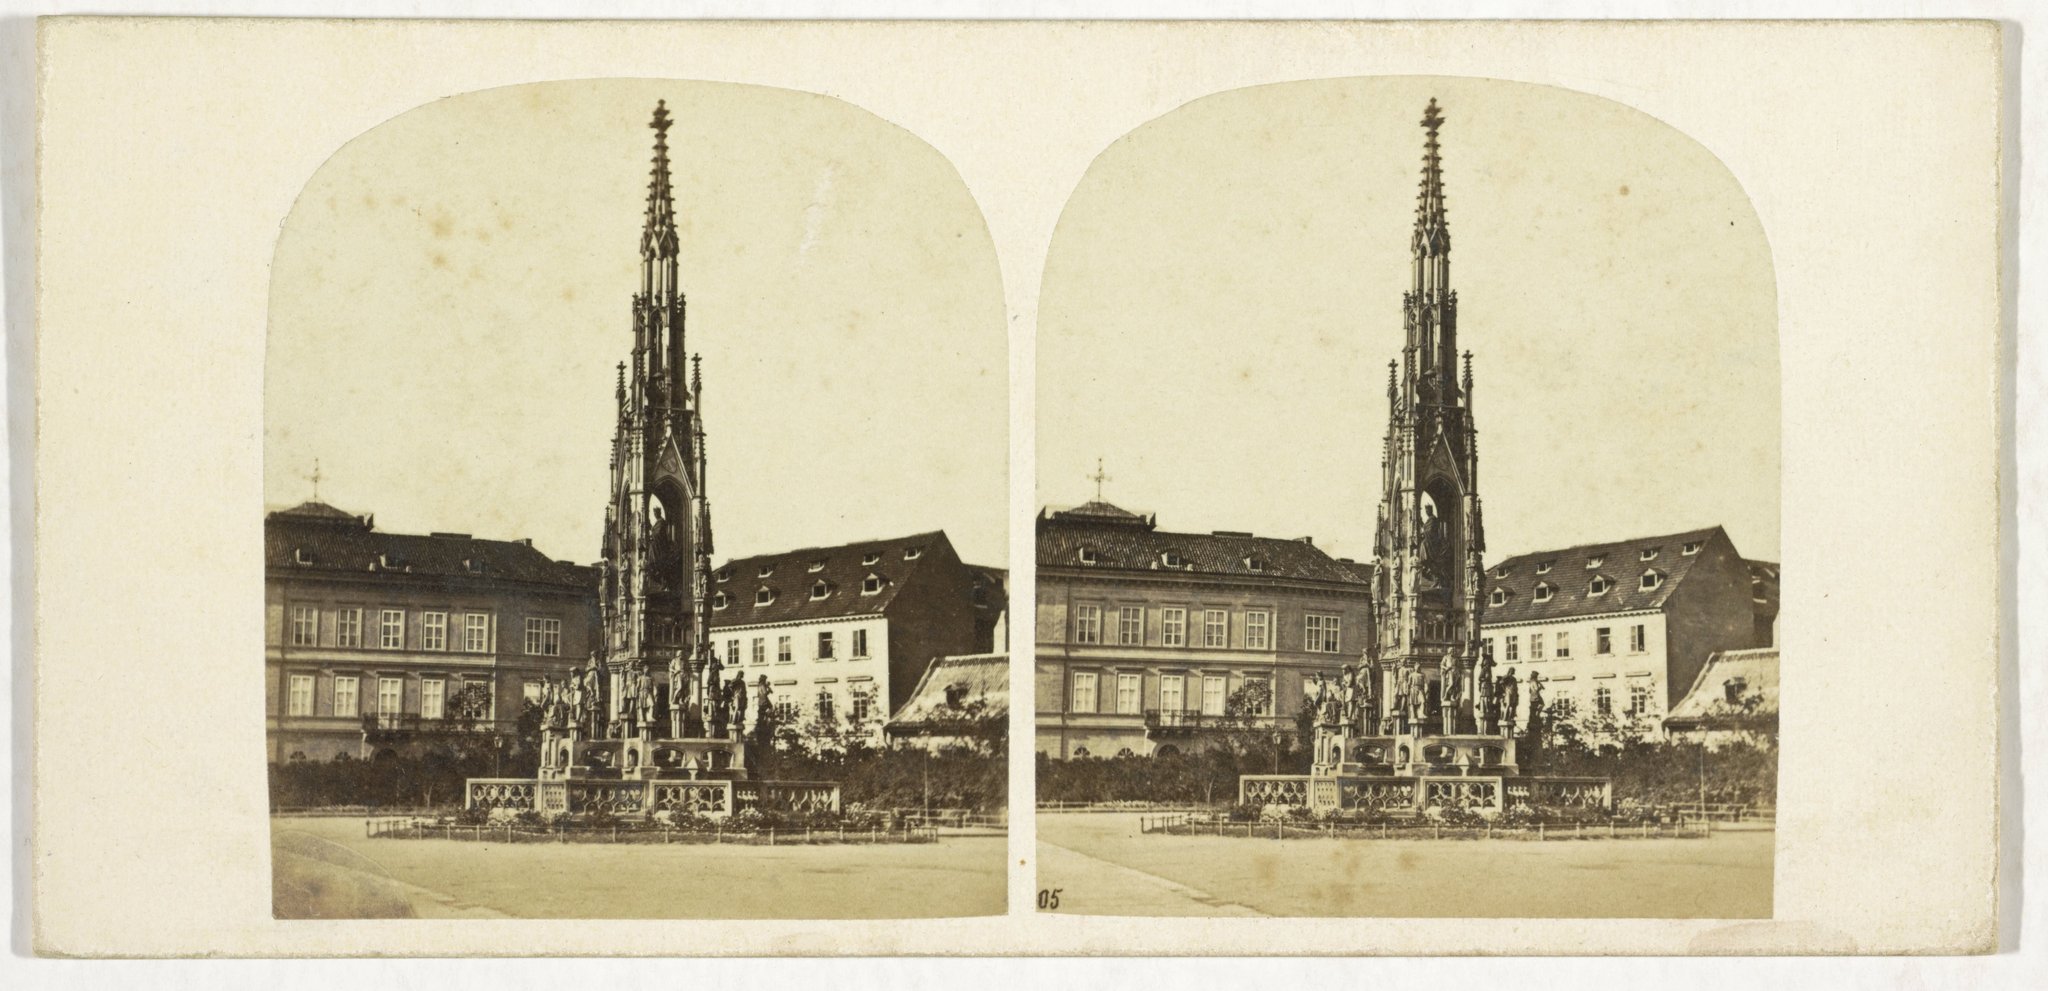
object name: stereograph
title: Monument de l'Empereur François, Prague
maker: Anonymous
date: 1857-1863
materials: cardboard, paper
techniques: albumen print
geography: prague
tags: monument, statue, prague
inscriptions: number: ‘05’